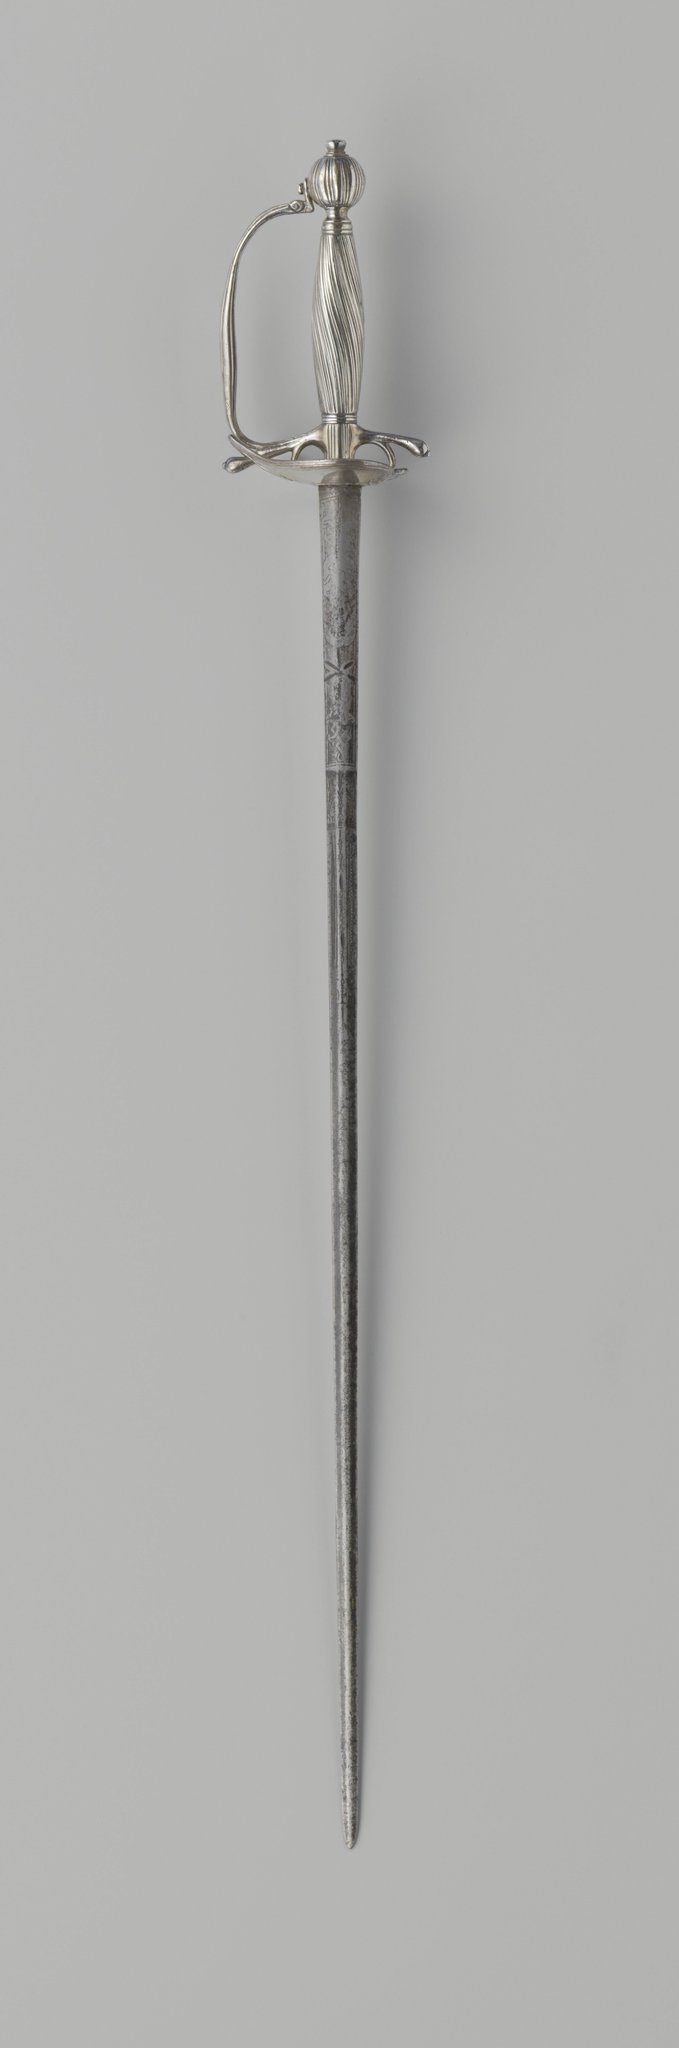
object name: sword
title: Degen met zilveren gevest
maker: abraham du cellieé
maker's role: zwaardveger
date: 1775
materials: iron, silver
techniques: printing, embroidery, etching, faceting, gilding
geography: amsterdam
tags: amsterdam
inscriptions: inscription: ‘L'HONEUR ME FAIT SERVIR’, mark: ‘ASV’, inscription: ‘Abm(superscript m) Du Celliee // Md(superscript d) fourbisseur // Franc (superscript c) ais // Dans Le // Calverstraat // a' Amsterdam (voorkant); Abraham // Du Celliee mr (superscript r) // Zwaardveger // In De // Kalverstraat // a' Amsterdam (achterkant)’